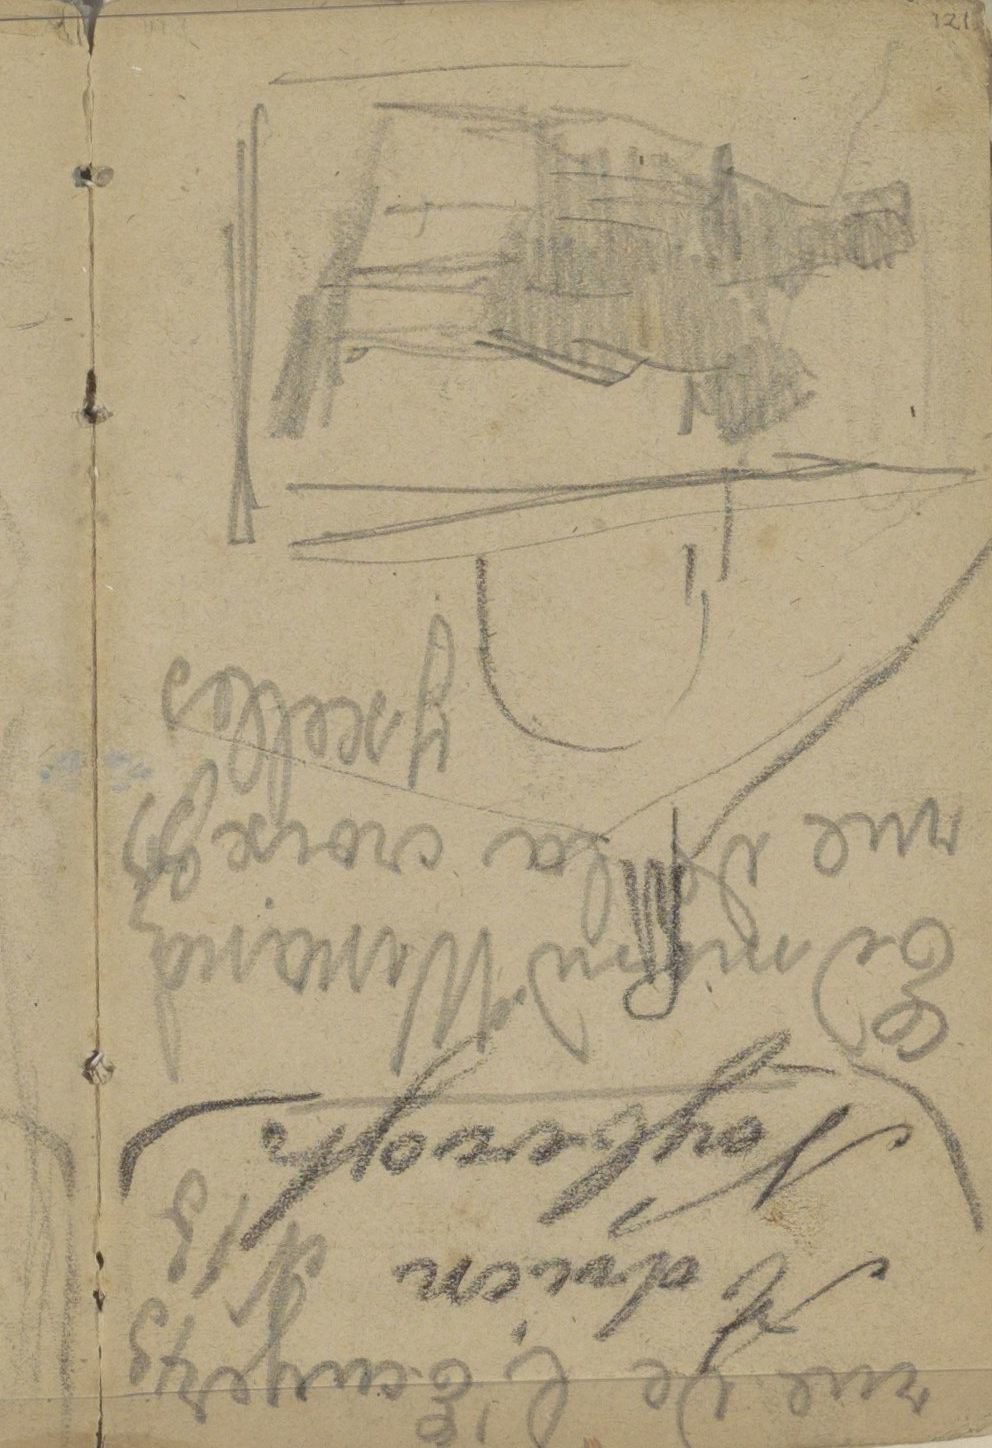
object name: sketchbook leaf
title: Twee figuren, mogelijk vrouwen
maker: george hendrik breitner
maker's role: draughtsman, painter, print maker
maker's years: 1857-1923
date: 1881-1883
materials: chalk, paper, pencil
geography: south holland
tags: adult woman (+ number of persons)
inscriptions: address: ‘rue de l'Ecuyer 43/ N 13’, name: ‘Adrien/ Neybergh’, address: ‘Edmond Winandy/ rue de la croise/ 37[?] Yxelles’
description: Twee figuren, mogelijk vrouwen. Pagina 121 uit een schetsboek met 70 bladen.